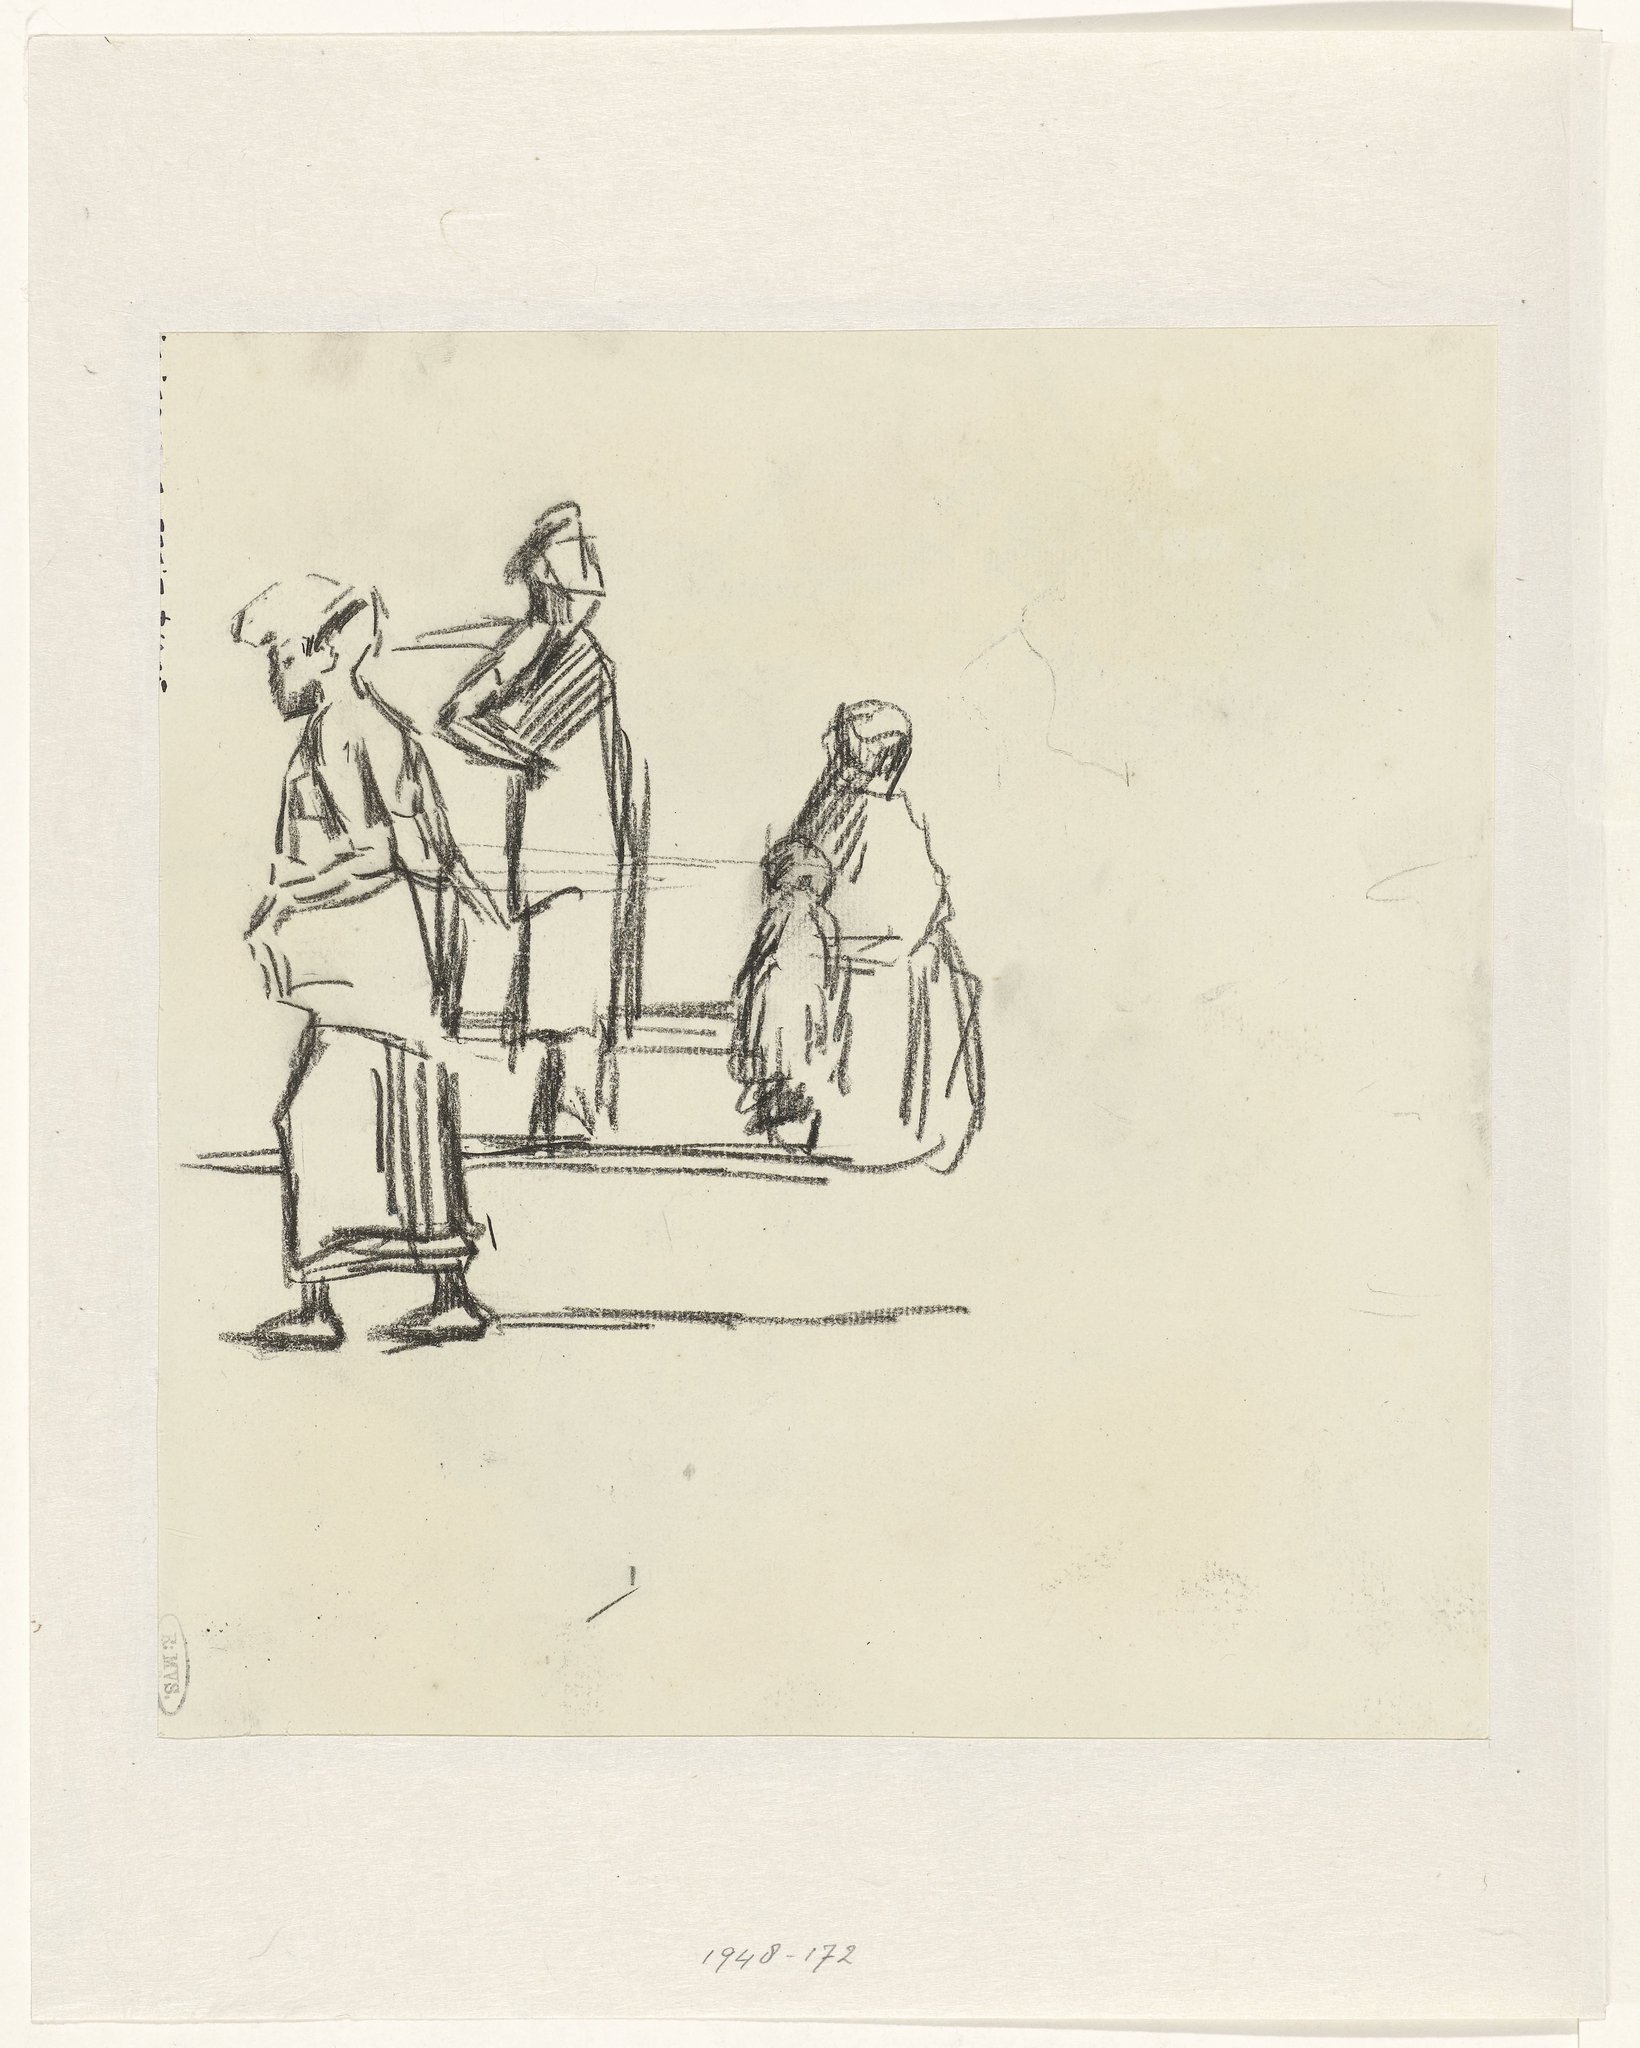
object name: drawing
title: Vier personen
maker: isaac israels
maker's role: draughtsman, painter, print maker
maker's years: 1865-1934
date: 1905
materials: chalk, paper